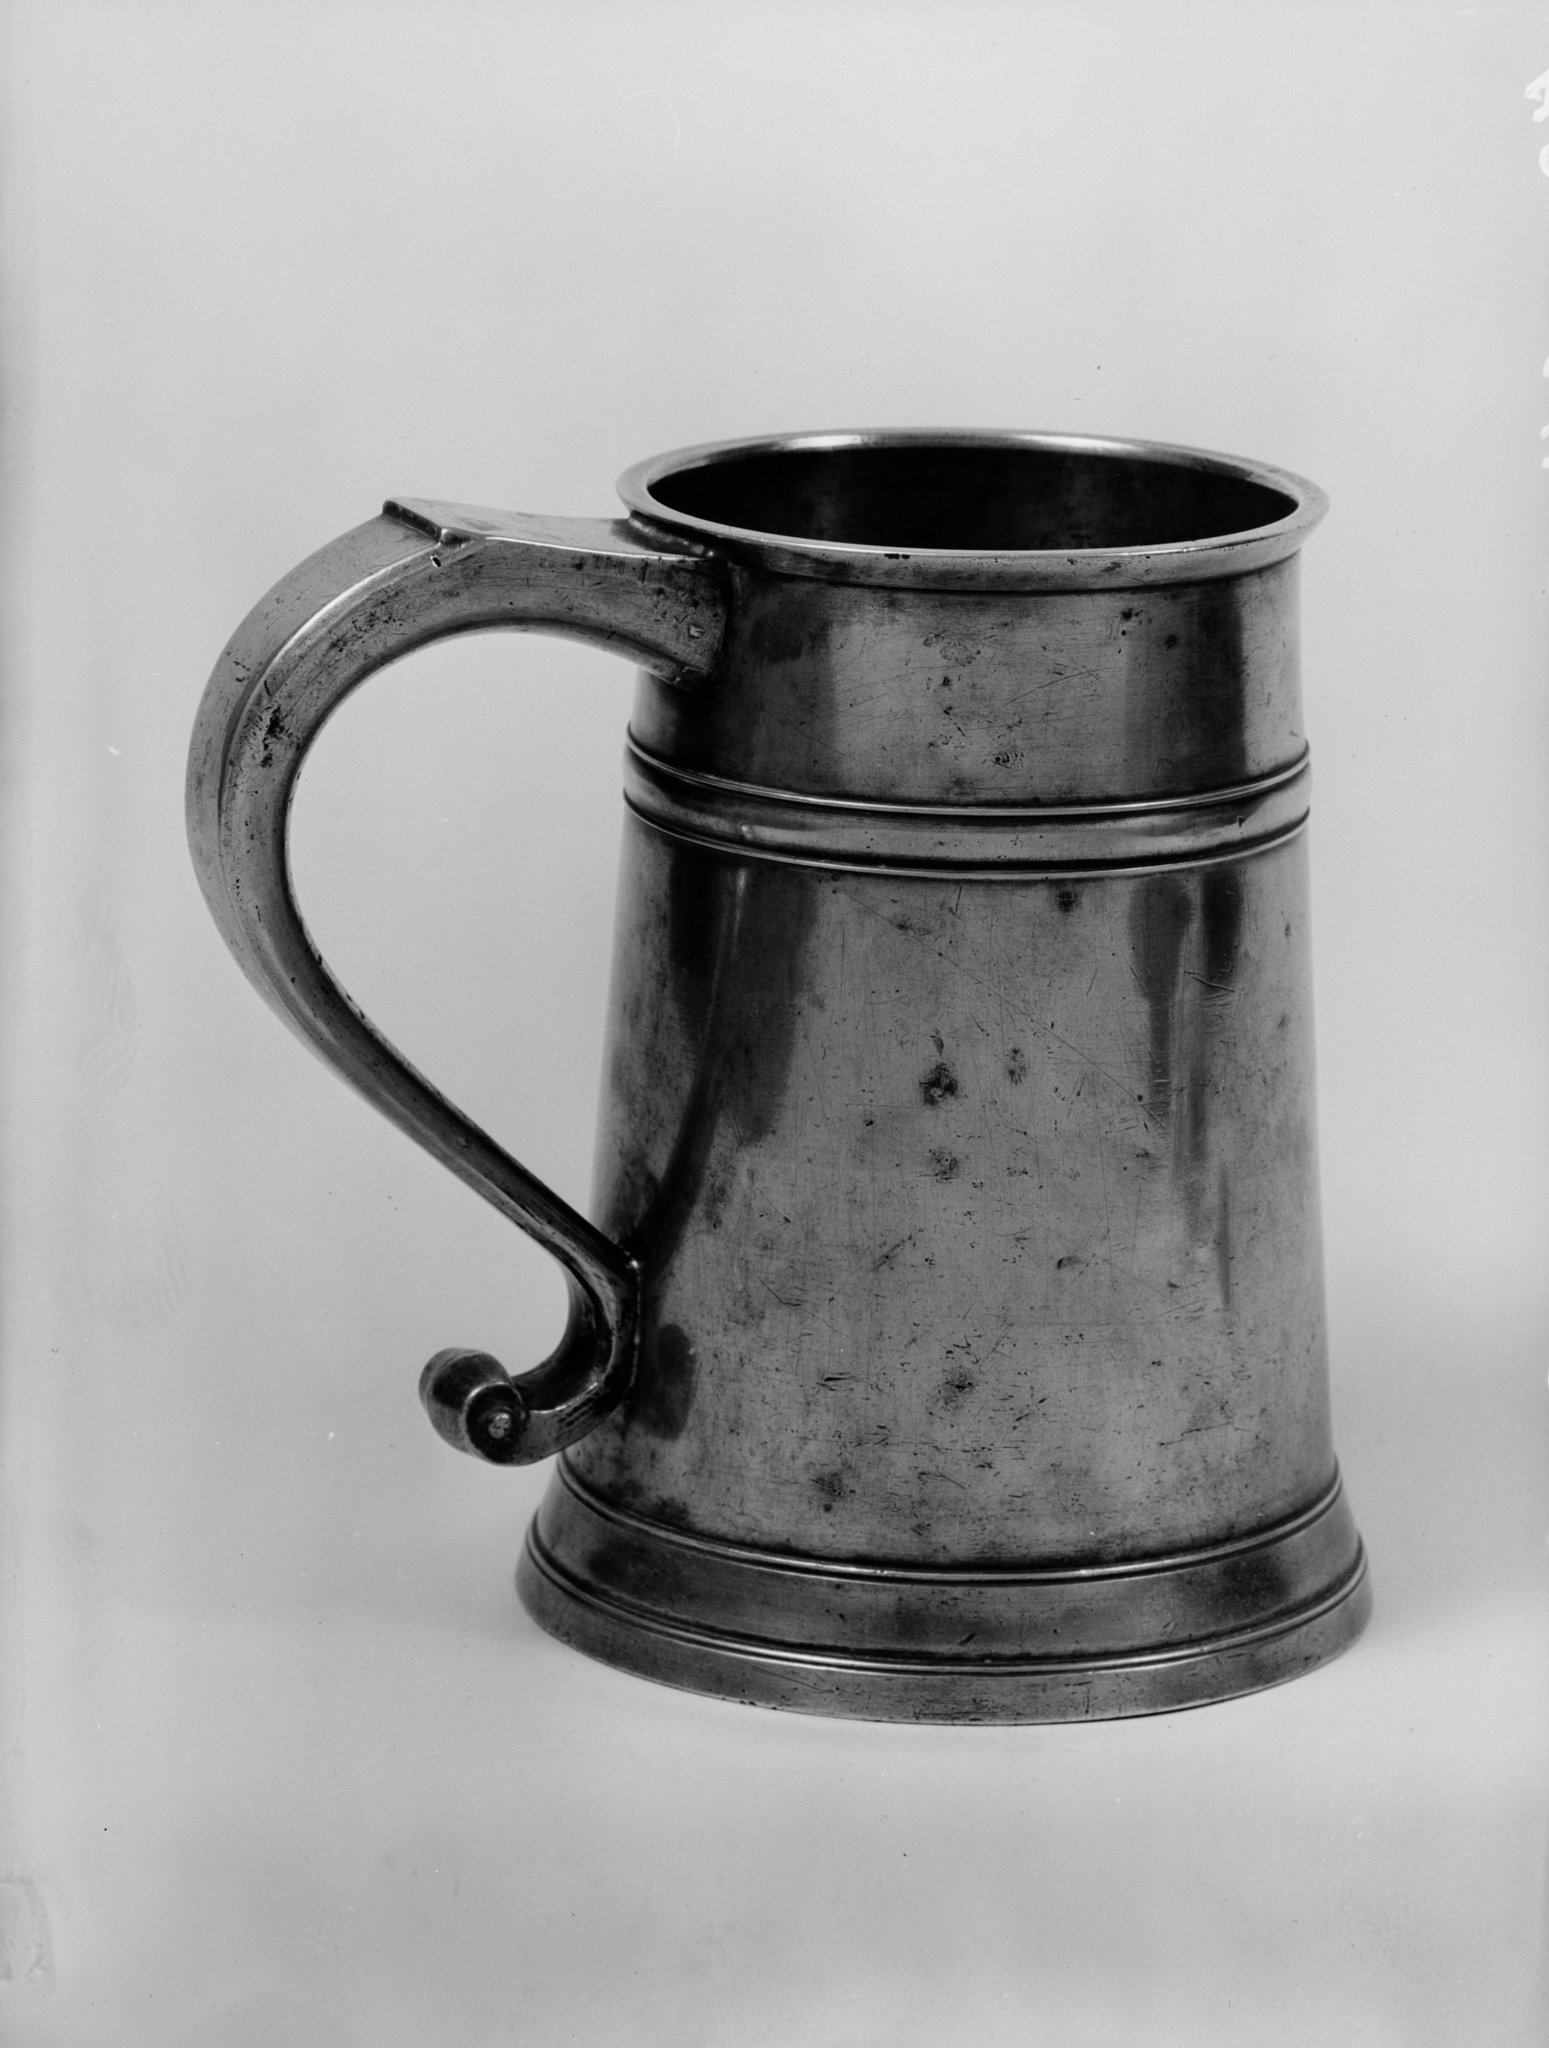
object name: mug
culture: american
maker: henry will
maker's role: maker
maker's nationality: american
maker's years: 1734-1802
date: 1761-1793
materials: pewter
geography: united states